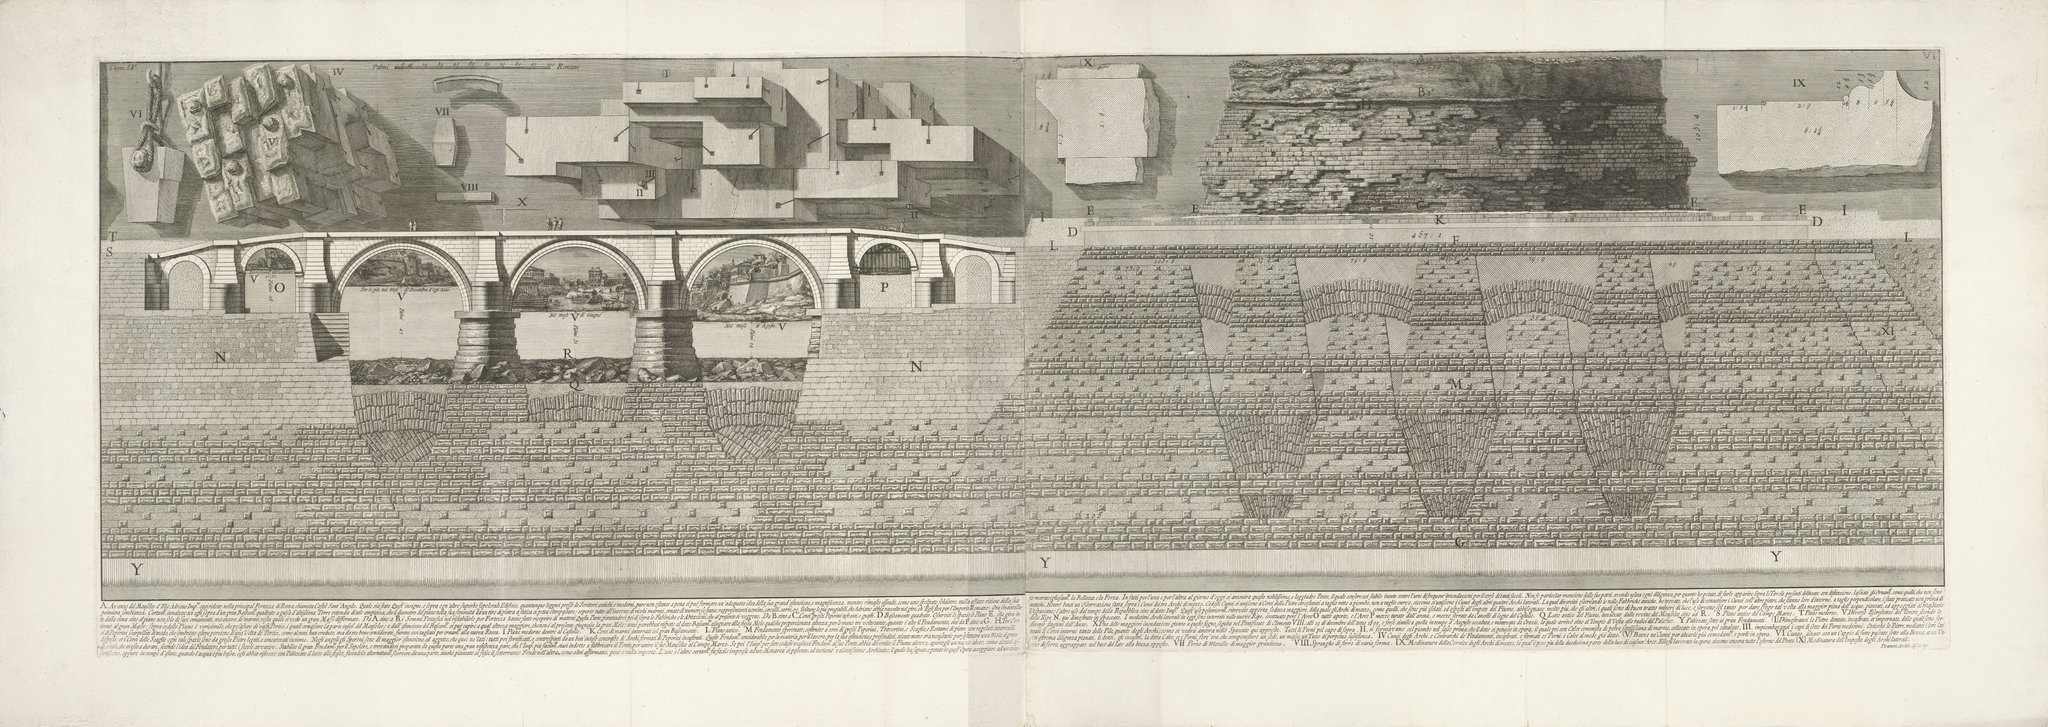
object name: print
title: Fundering van de Engelenburcht en de Engelenbrug te Rome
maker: giovanni battista piranesi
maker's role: designer, draughtsman, print maker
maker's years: 1720-1778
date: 1756-1757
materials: paper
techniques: etching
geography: rome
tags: mausoleum, bridge, rome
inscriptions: collector's mark: Lugt 2228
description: Deze prent maakt deel uit van de serie 'Le Antichità Romane'. Piranesi deed meer dan acht jaar voorstudie voor deze 250 platen tellende serie die in vier volumes werd uitgegeven. Hij produceerde de prenten tussen ca. 1756 en 1757. De serie bevat ook prenten door of naar andere prentmakers, onder wie Francesco Bianchini en Girolamo Rossi.